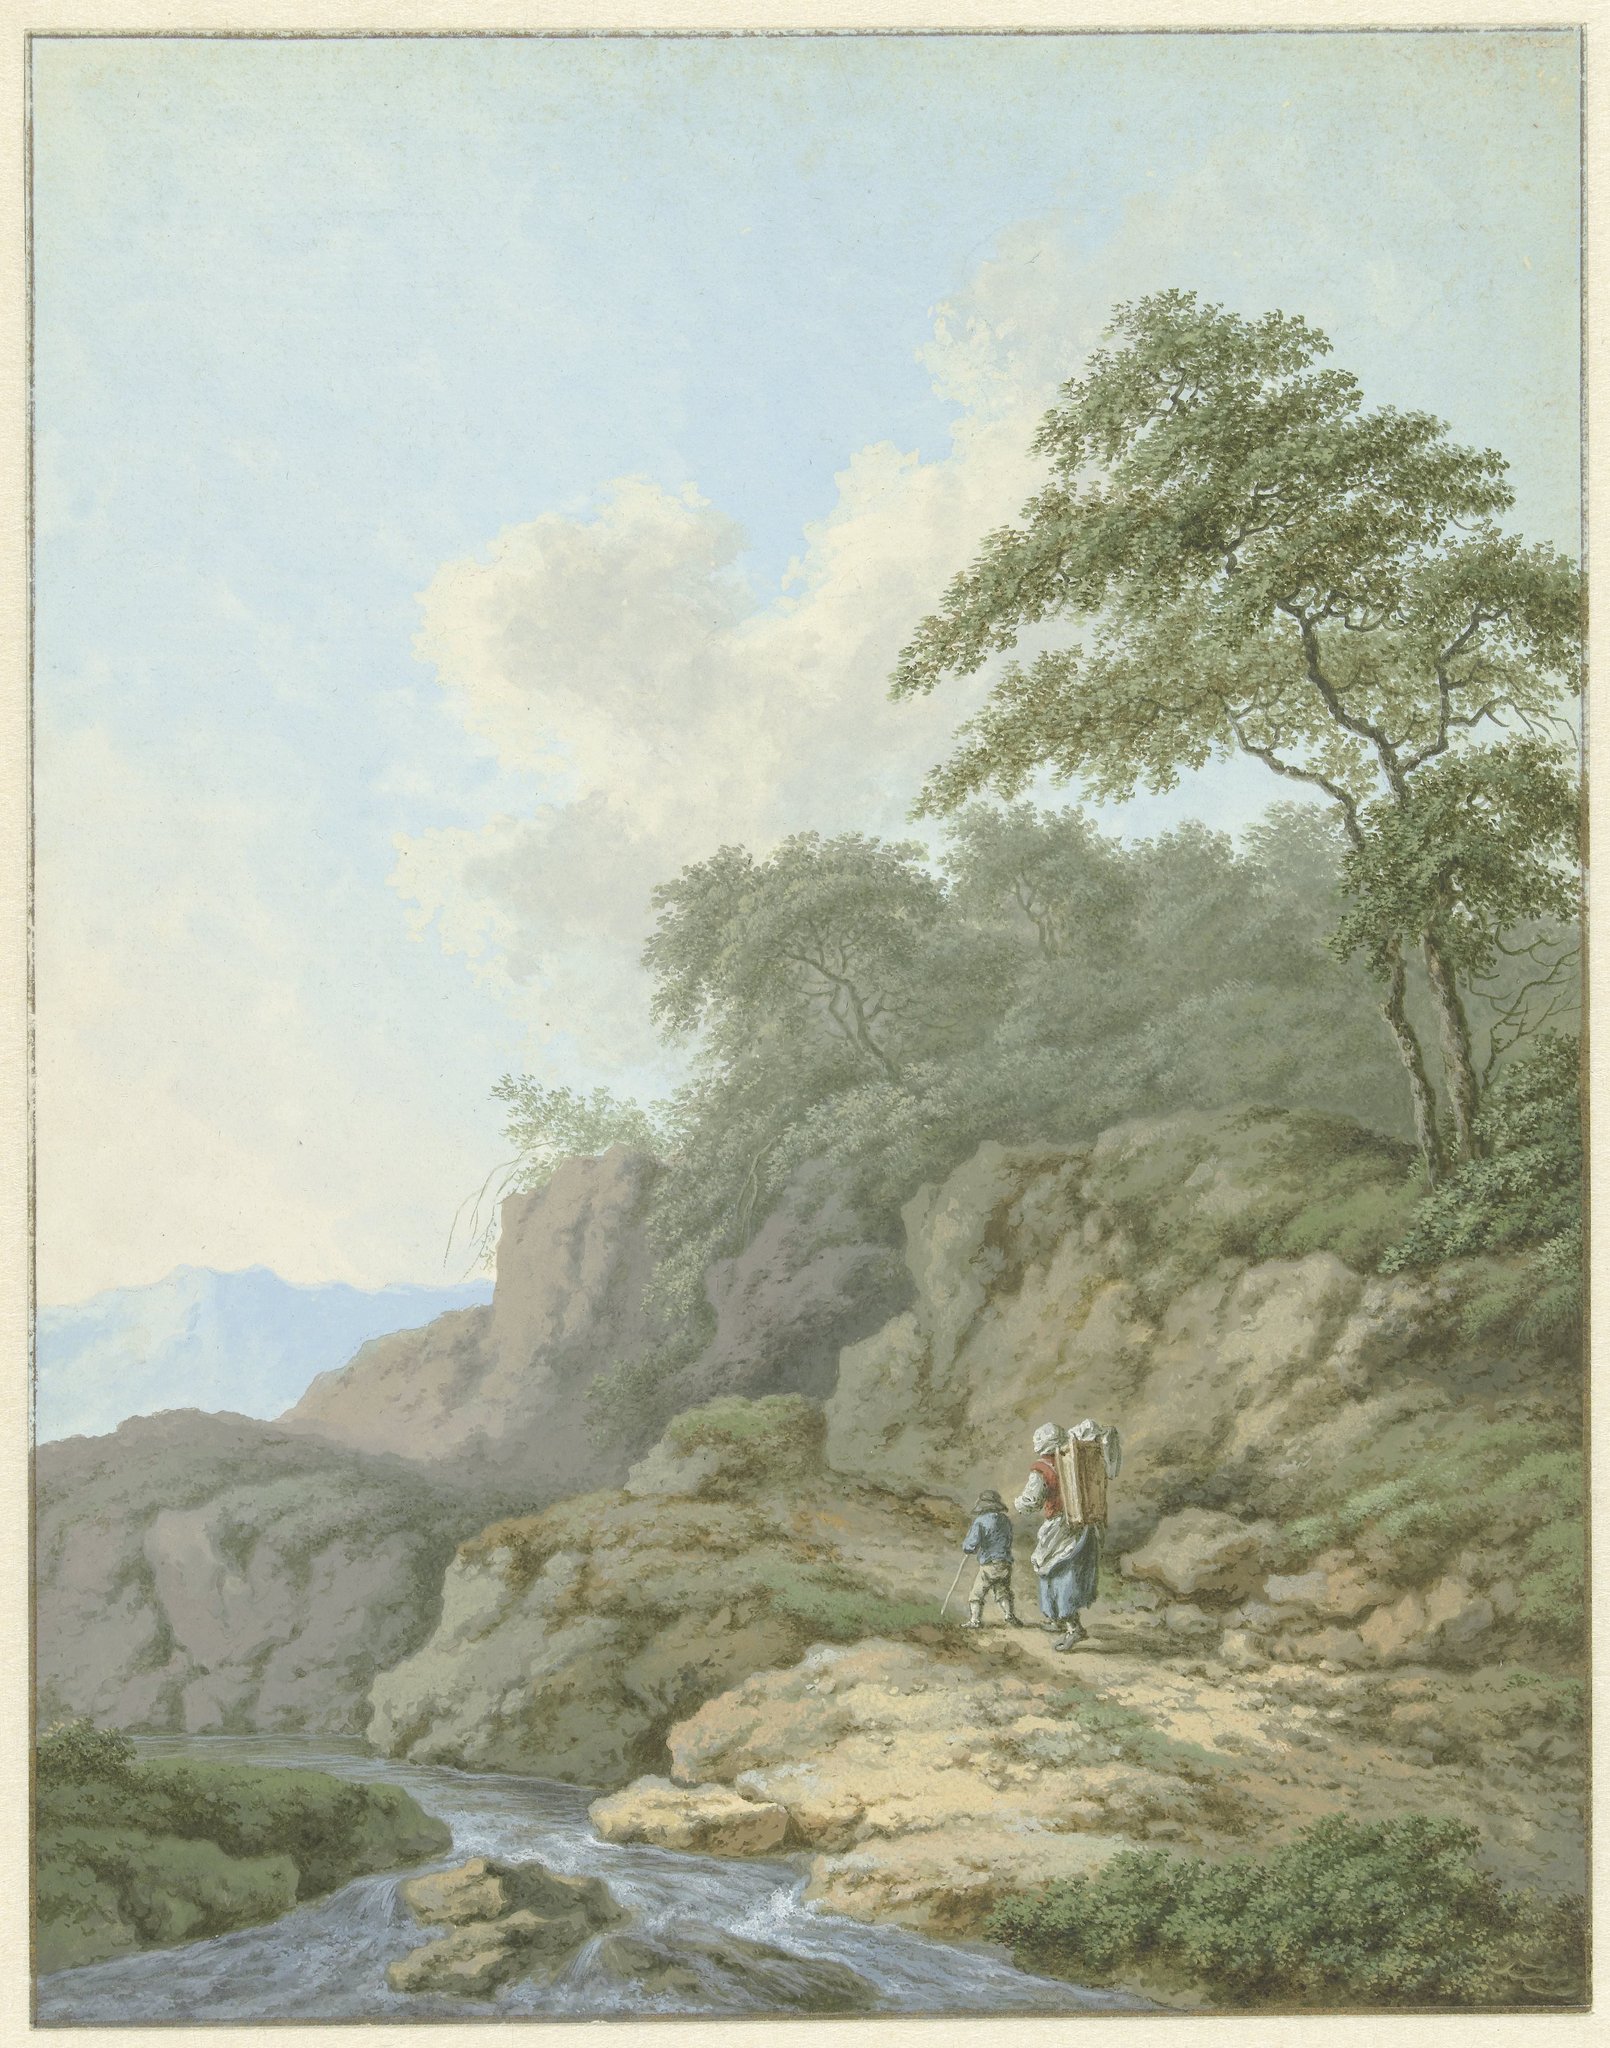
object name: drawing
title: Landschap met vrouw en jongen onderweg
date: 1700-1800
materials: gouache, paper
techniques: brush